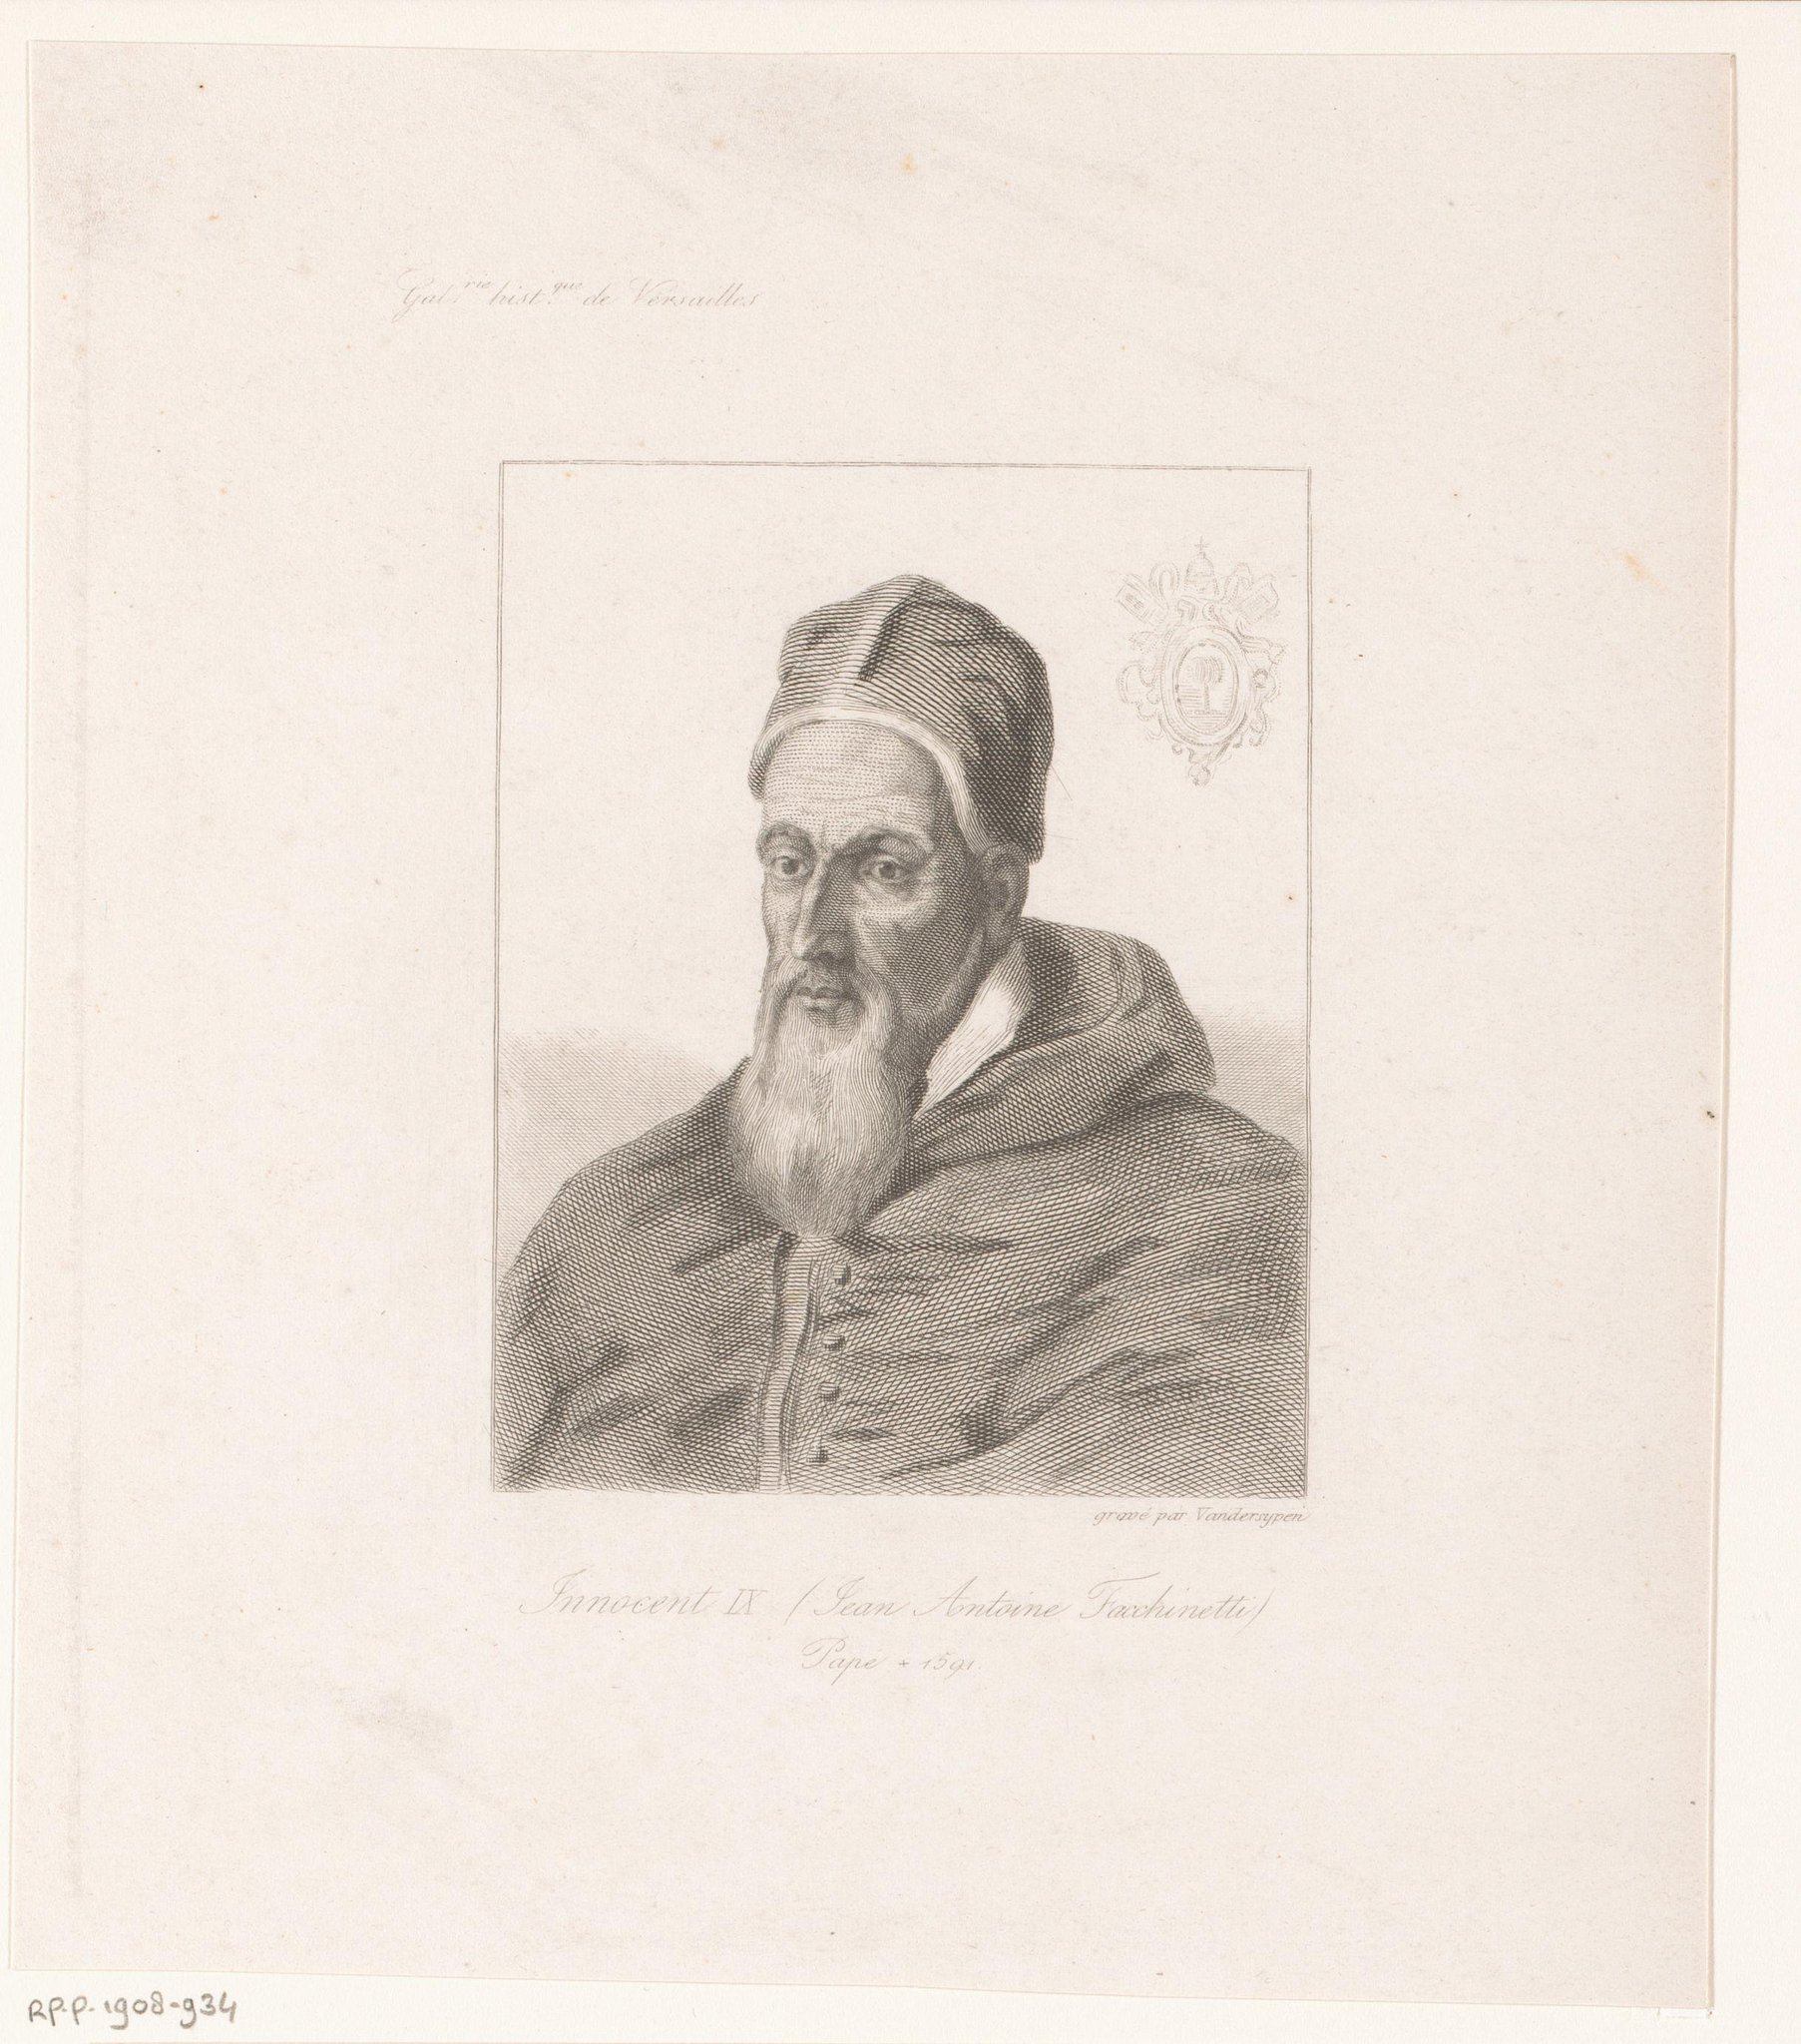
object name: print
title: Innocent IX (Jean Antoine Facchinetti) Pape 1591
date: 1827-1881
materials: paper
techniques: engraving, etching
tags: historical persons, pope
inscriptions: collector's mark: Lugt 2228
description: Linksboven vermeld: Galrie. Histque. de Versailles.